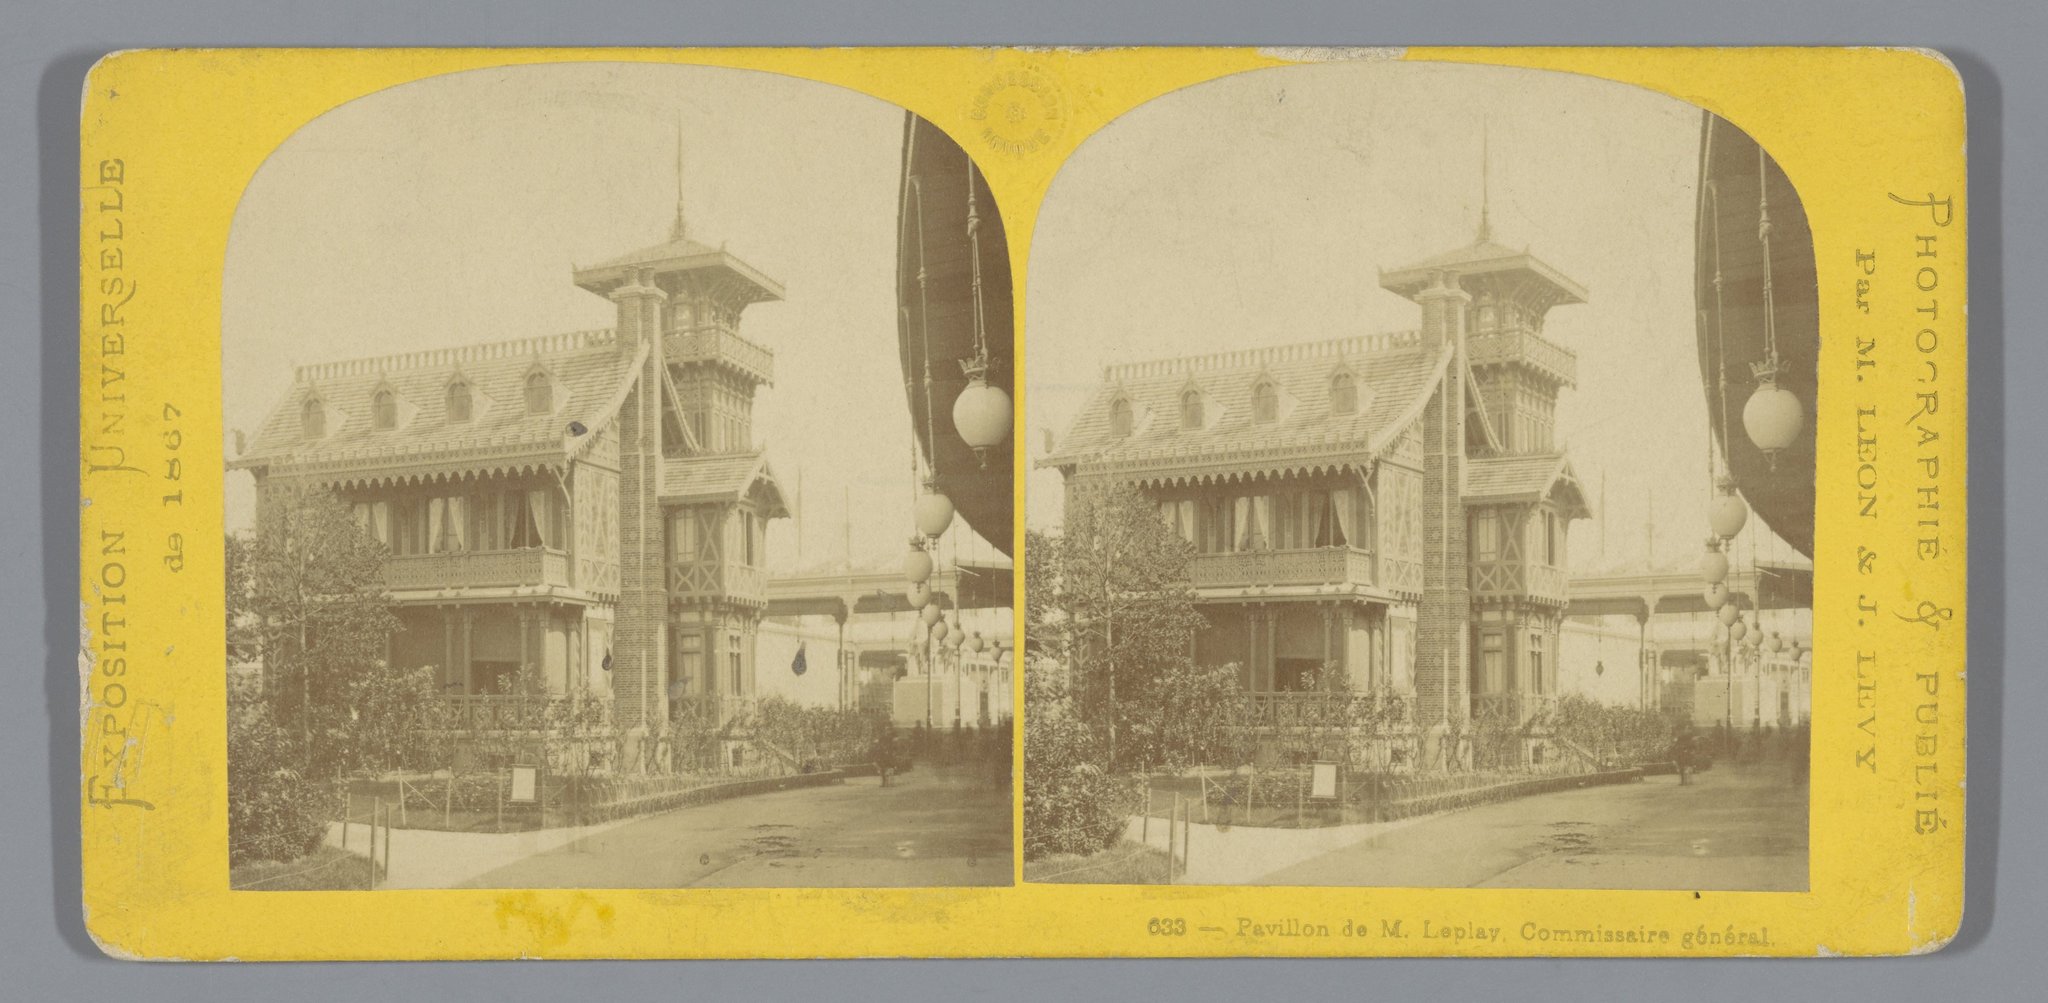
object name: stereograph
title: Pavillon de M. Leplay, commissaire general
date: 1867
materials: cardboard, paper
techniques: albumen print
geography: paris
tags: world fair, world exhibition, paris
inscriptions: check stamp: ‘CONCESSION/ */ UNIQUE’, number: ‘633’